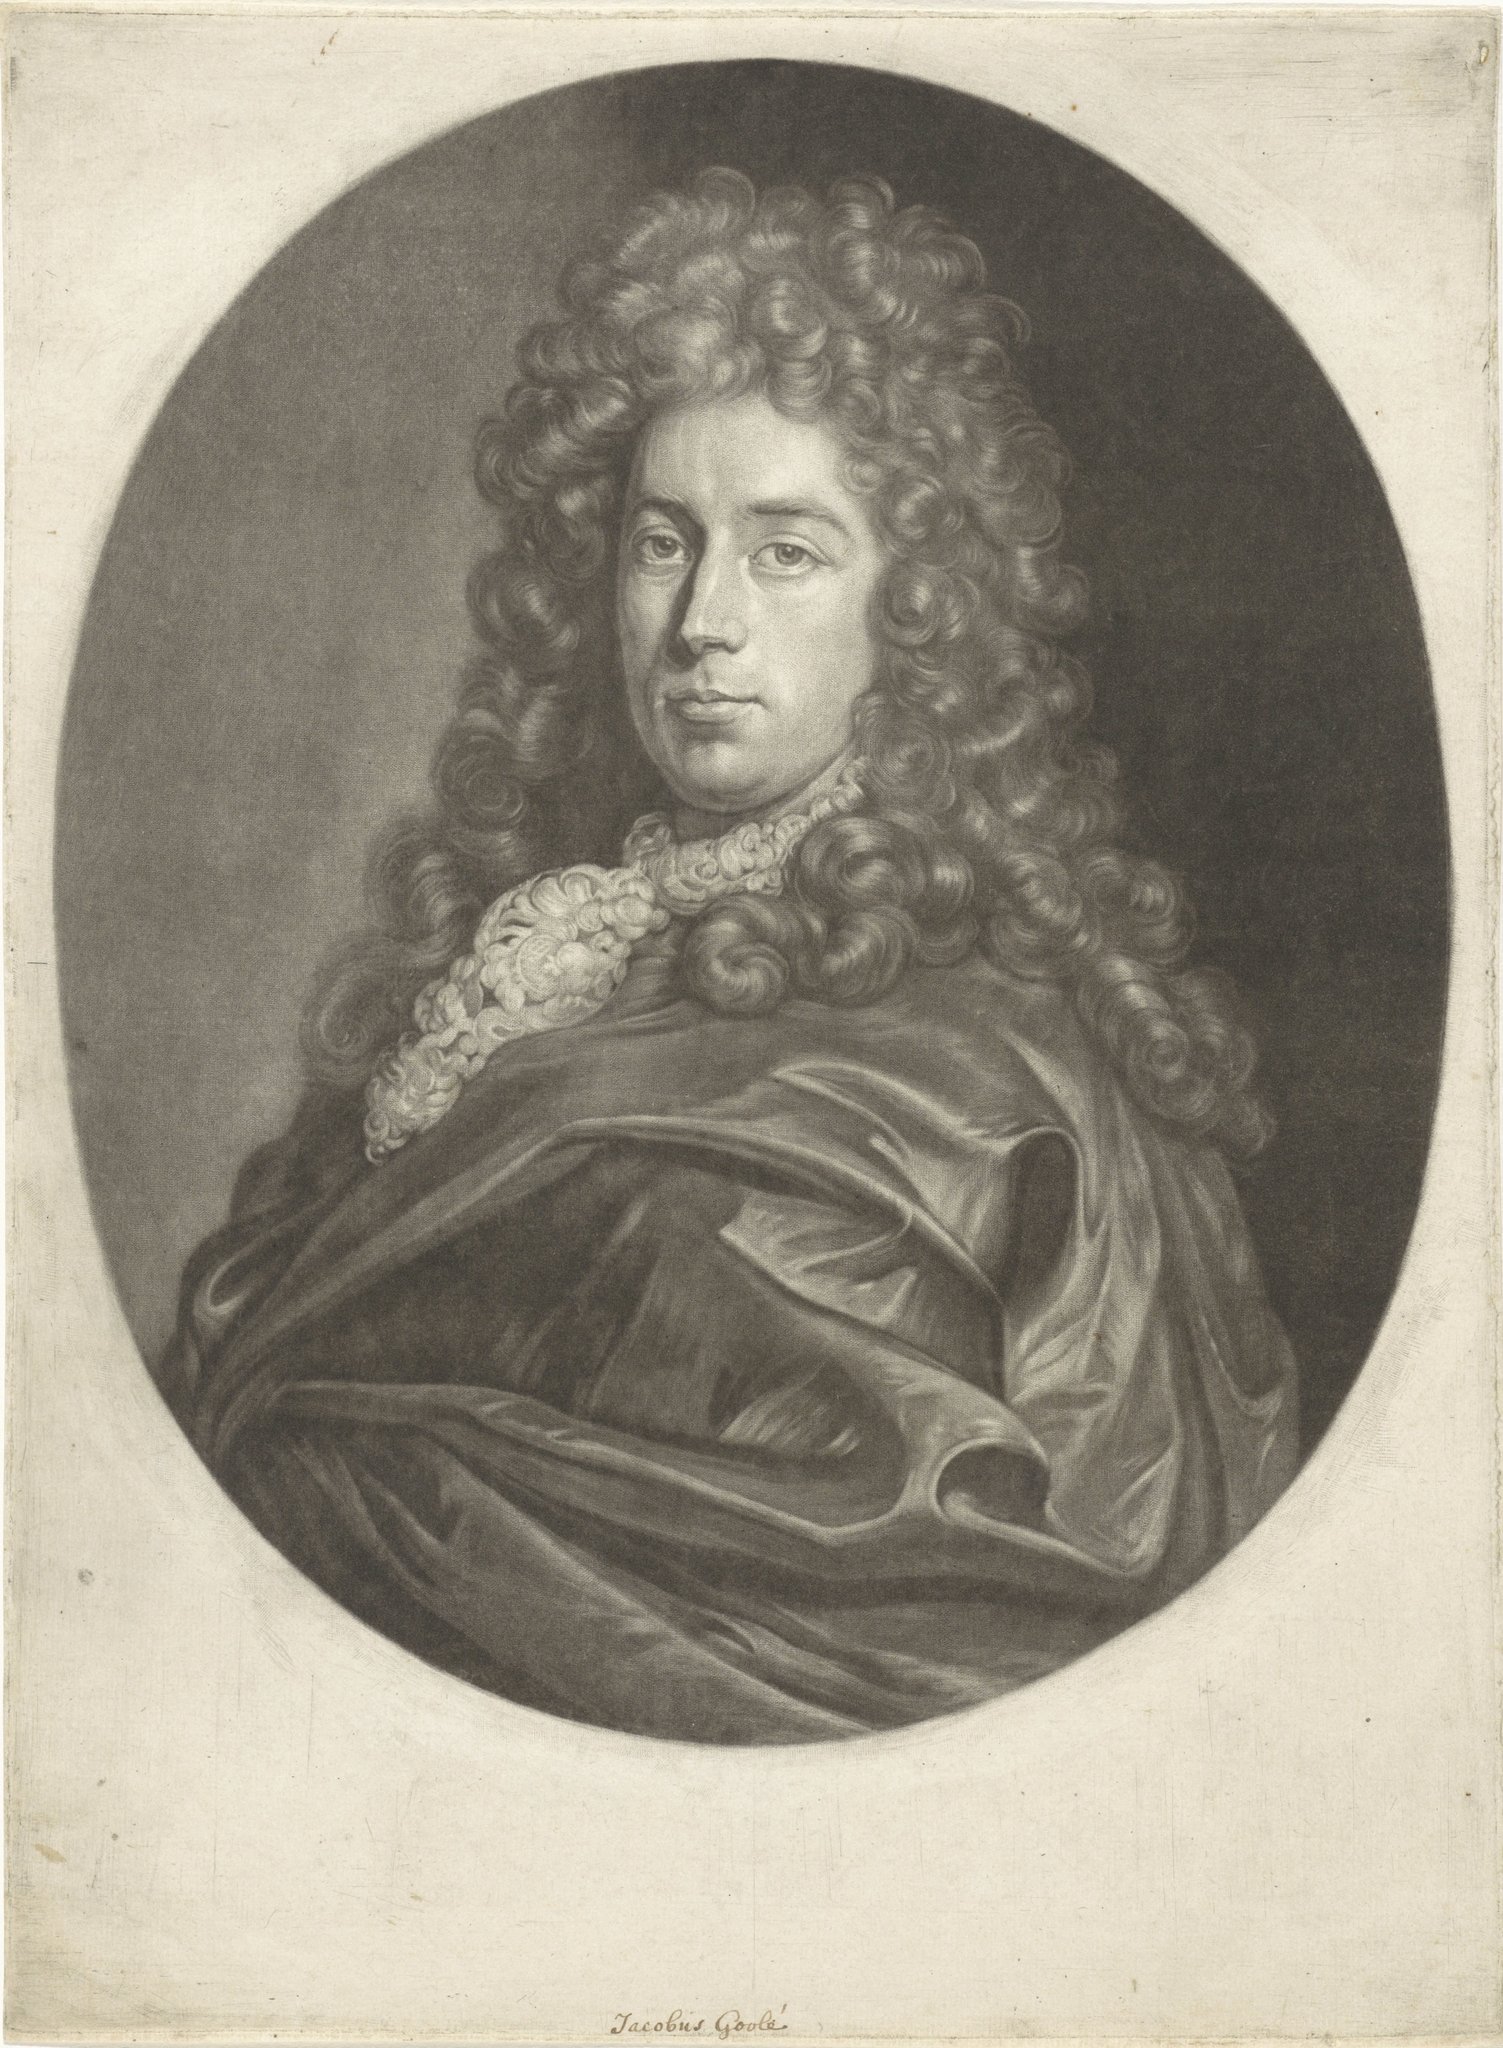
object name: print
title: Zelfportret van Jacob Gole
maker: jacob gole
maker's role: print maker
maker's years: 1660-1724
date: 1680-1724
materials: paper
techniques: mezzotint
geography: amsterdam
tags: print maker, jacob gole, portrait, self-portrait of artist, wig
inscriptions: collector's mark: Lugt 2228